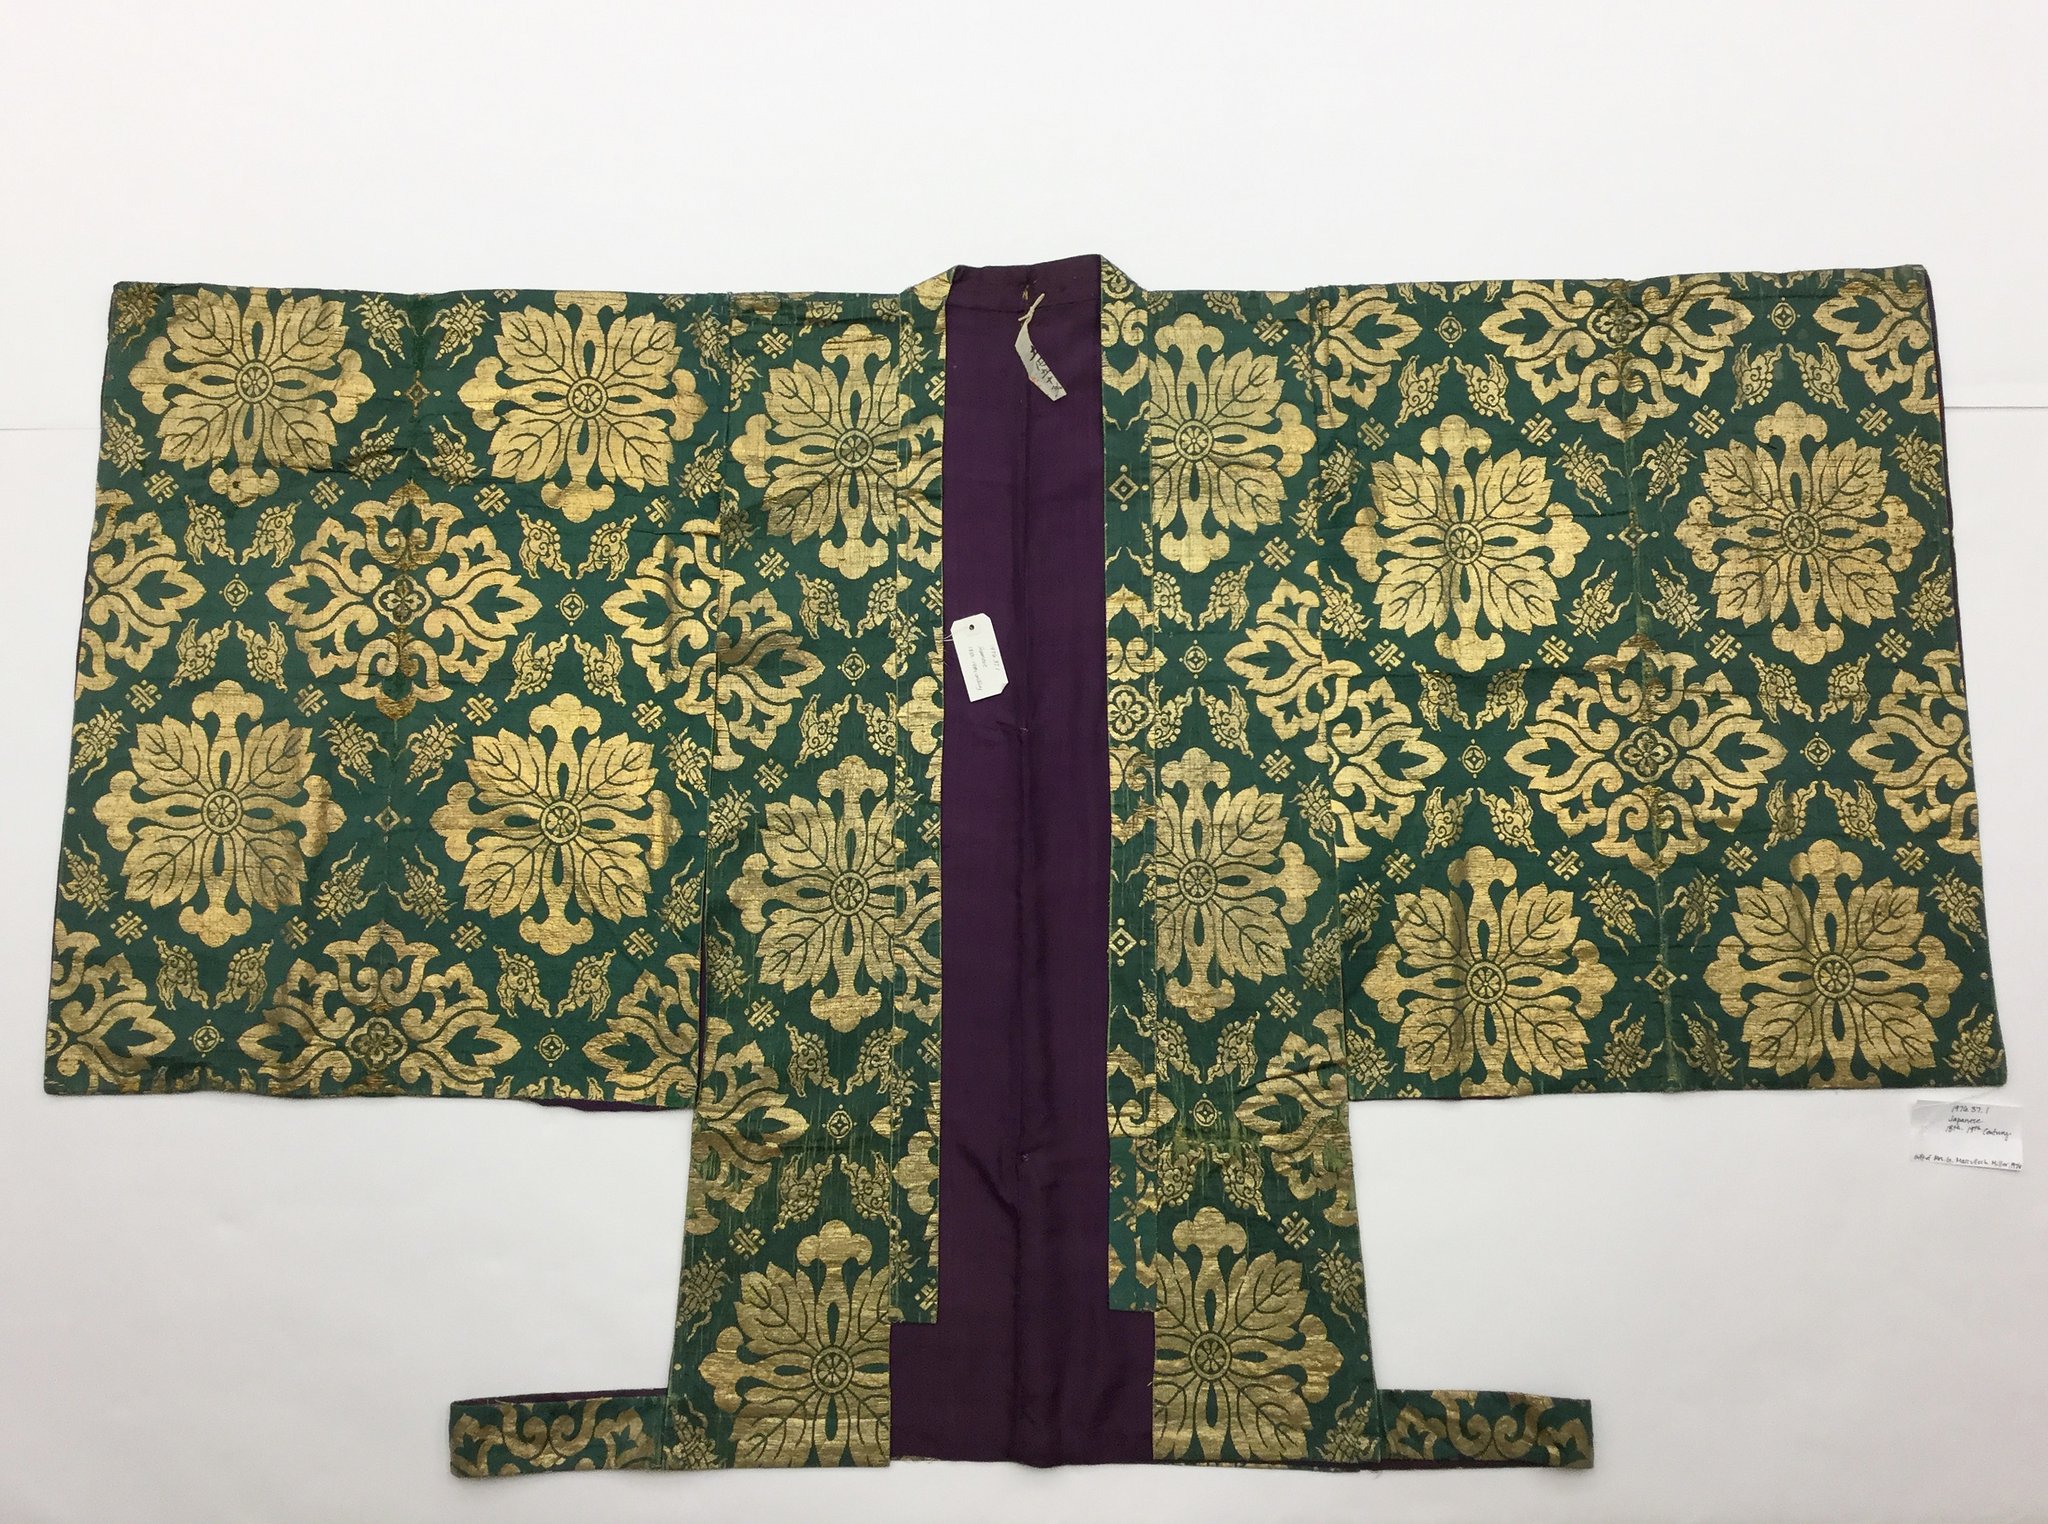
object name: jacket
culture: japanese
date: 1701-1900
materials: paper, silk